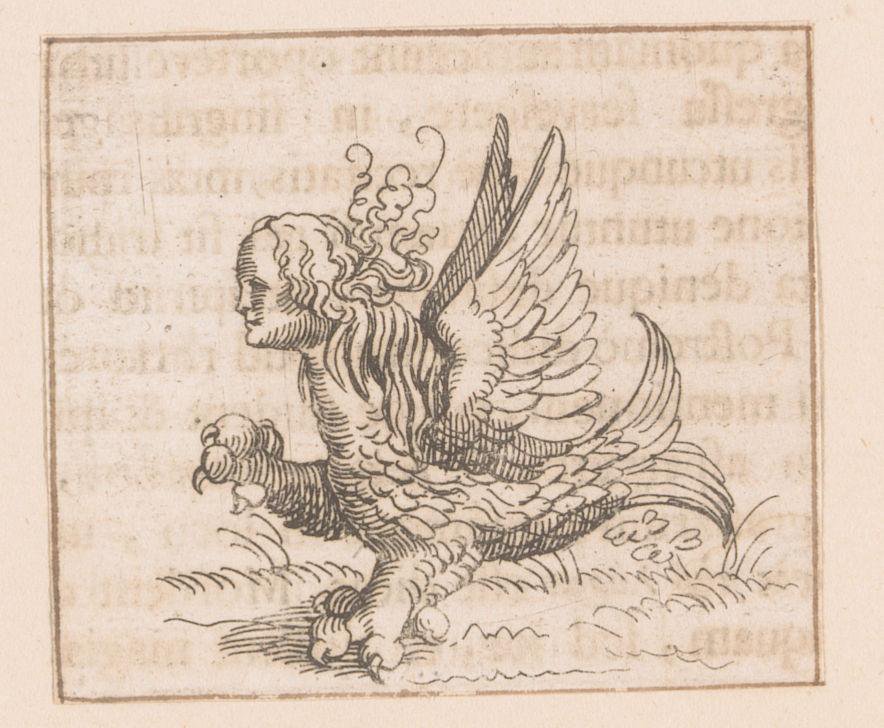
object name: book illustration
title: Chimaera zoals beschreven door Horatius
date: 1516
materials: paper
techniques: etching, letterpress printing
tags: rotterdam, desiderius erasmus, chimera (lion/goat/snake); 'chimera' (ripa)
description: Prent afkomstig uit: Erasmus, Desiderius. Morias enkomion (...). Bazel: Johann Rudolf Genath, 1676. De prenten hierin zijn naar tekeningen die Hans en Ambrosius Holbein maakten voor de theoloog Oswald Myconius in diens uitgave van de Moriae encomium (Lof der Zotheid) van 1516.